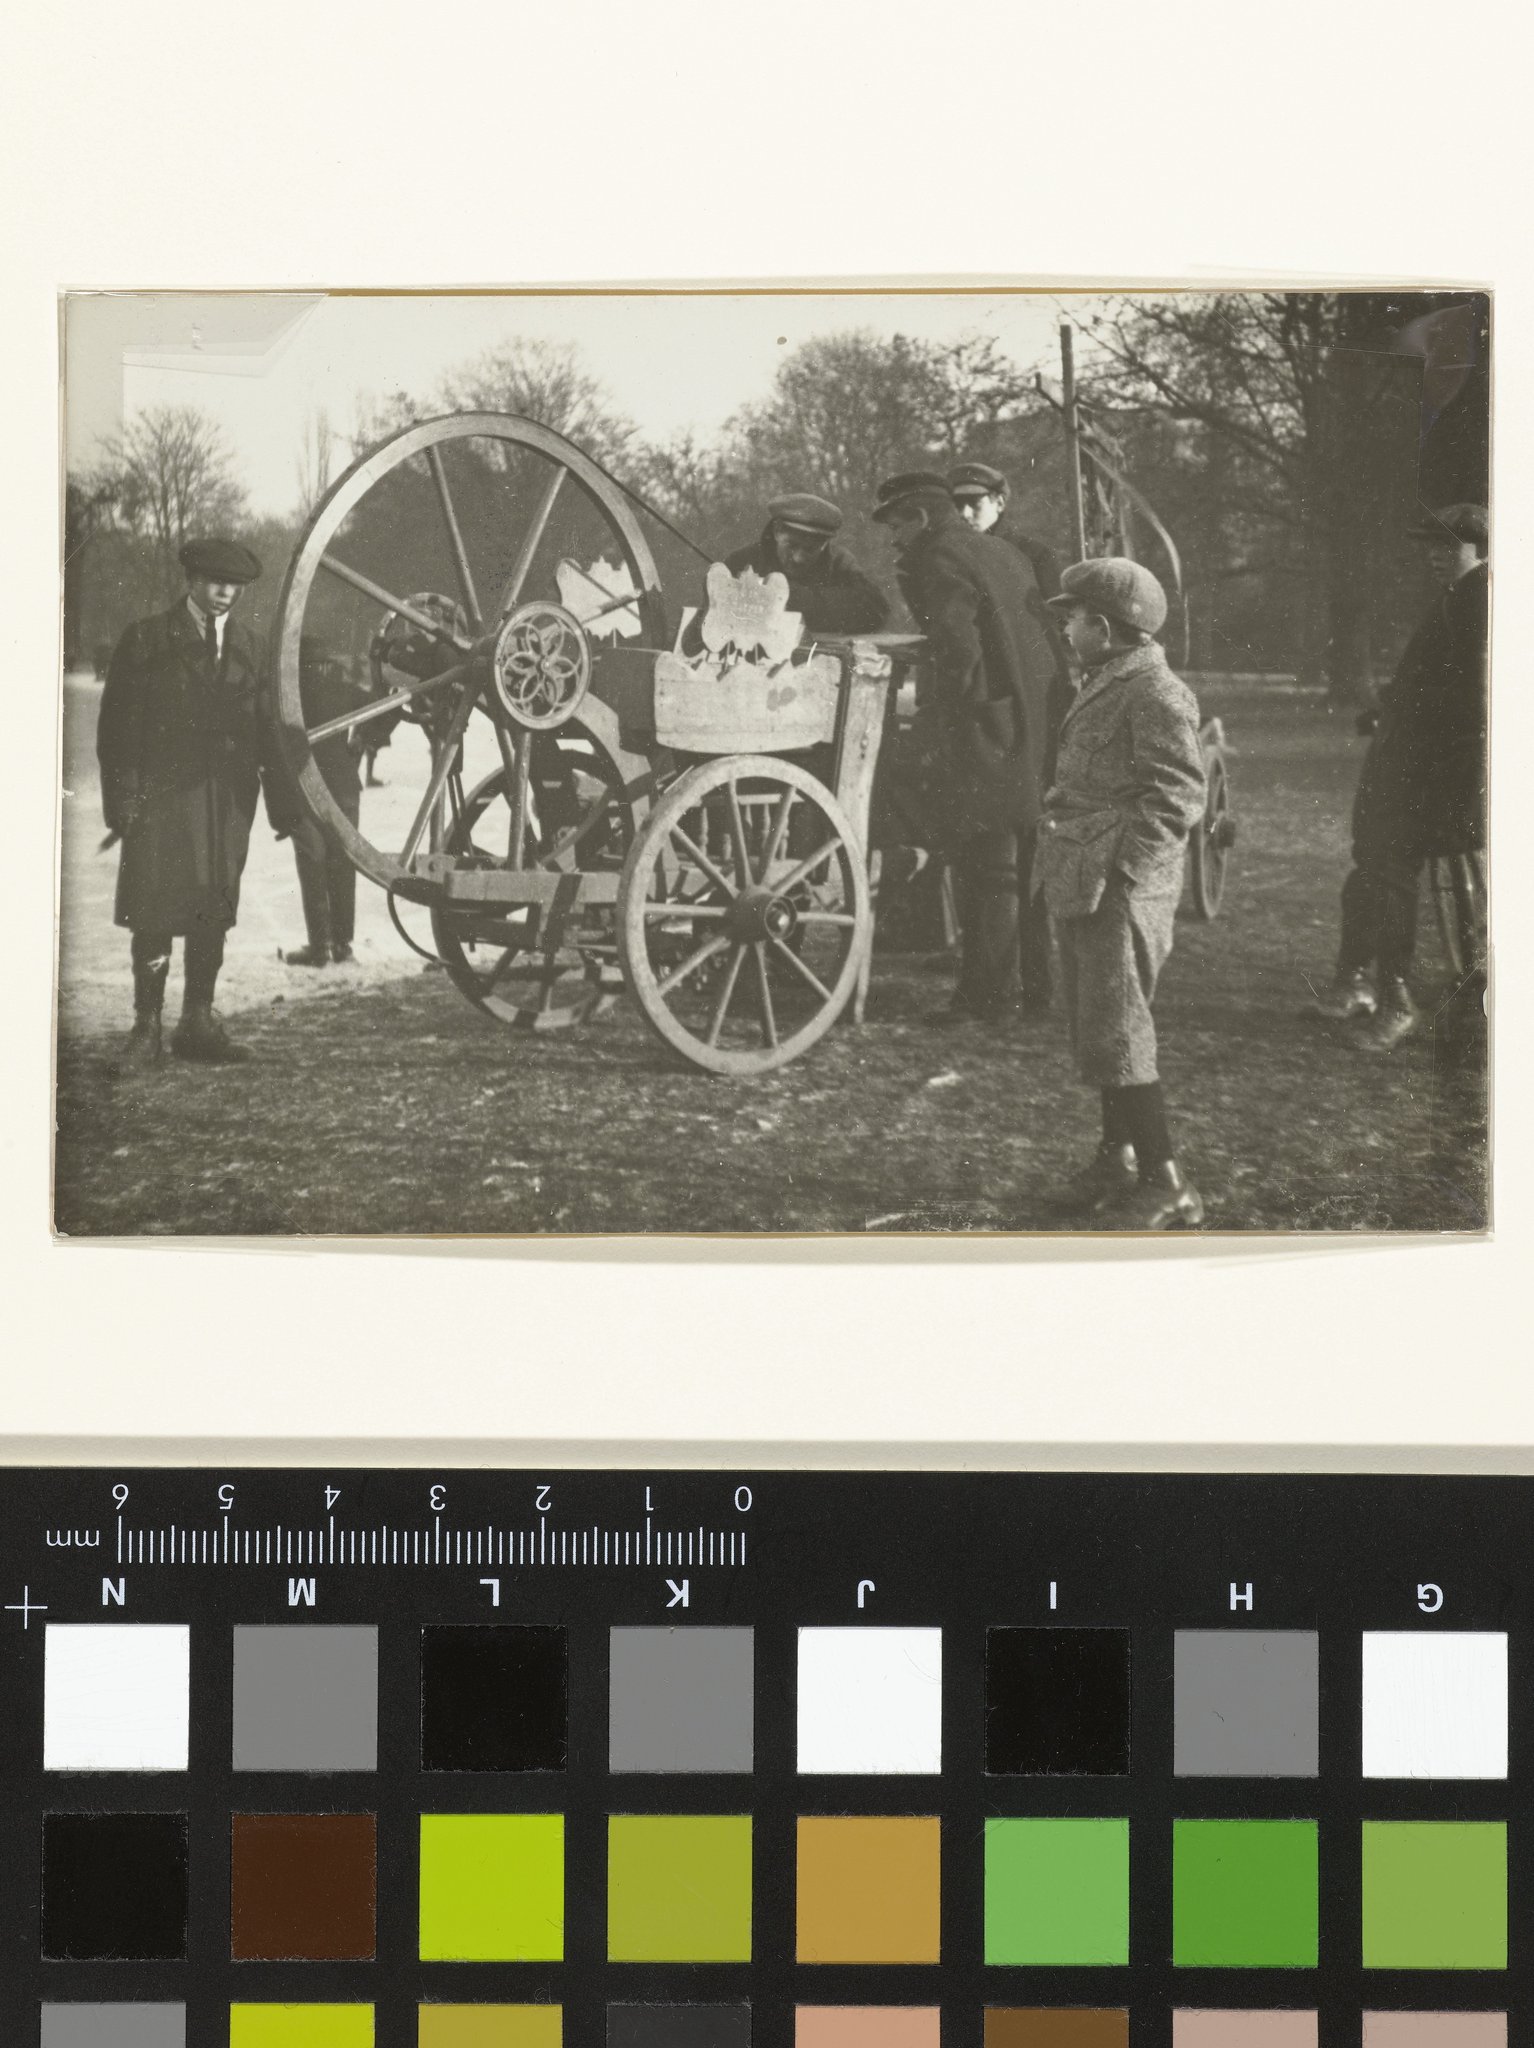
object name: ansichtkaart, prentbriefkaart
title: Schaatsenslijper in het Vondelpark, Amsterdam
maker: e. opperman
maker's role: publisher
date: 1920-1940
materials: paper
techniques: gelatin silver print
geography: amsterdam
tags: skates (winter sports)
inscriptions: stamp: ‘Ed. Opperman, Prinsengracht 1037’